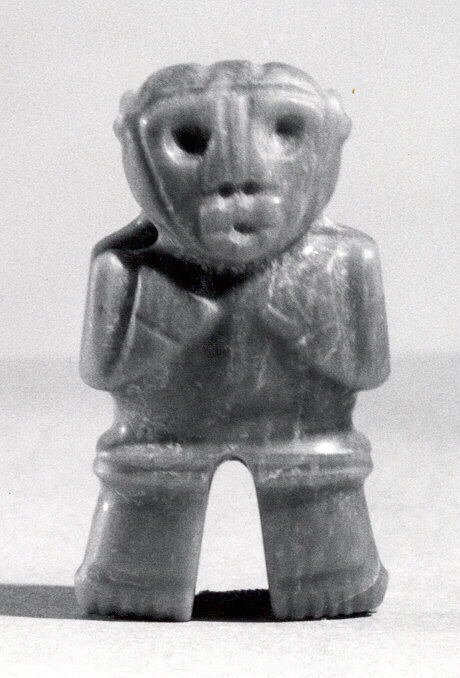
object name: pendant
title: Figure Pendant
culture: atlantic watershed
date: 301-800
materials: jade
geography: costa rica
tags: human figures